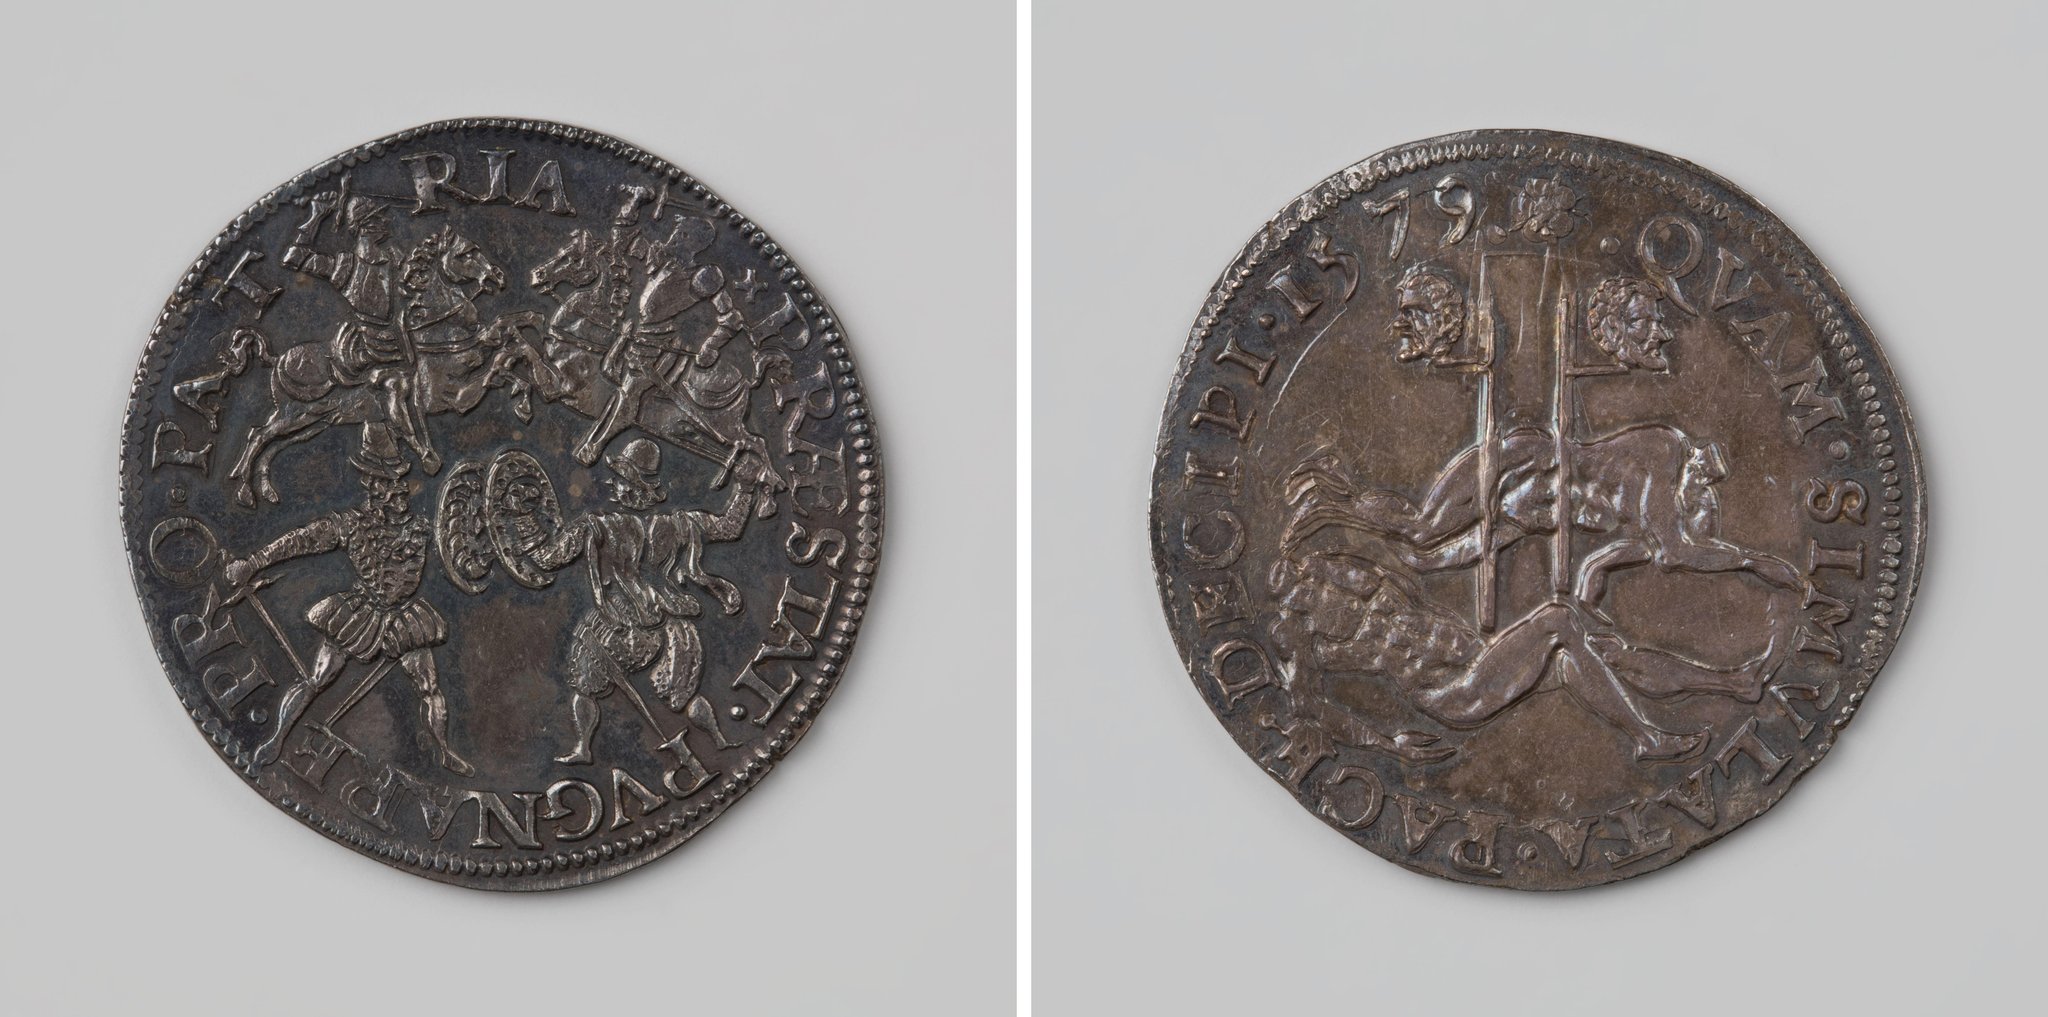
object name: jeton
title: Waarschuwing tegen de vredesonderhandelingen te Keulen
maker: gerard van bylaer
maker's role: die cutter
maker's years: 1540-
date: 1579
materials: silver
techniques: striking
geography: dordrecht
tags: earl, cologne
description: Zilveren penning. Voorzijde: twee ruiters en twee soldaten te voet met elkaar in gevecht binnen omschrift. Keerzijde: twee lijken, waarvan de hoofden op staken zijn geplaatst binnen omschrift